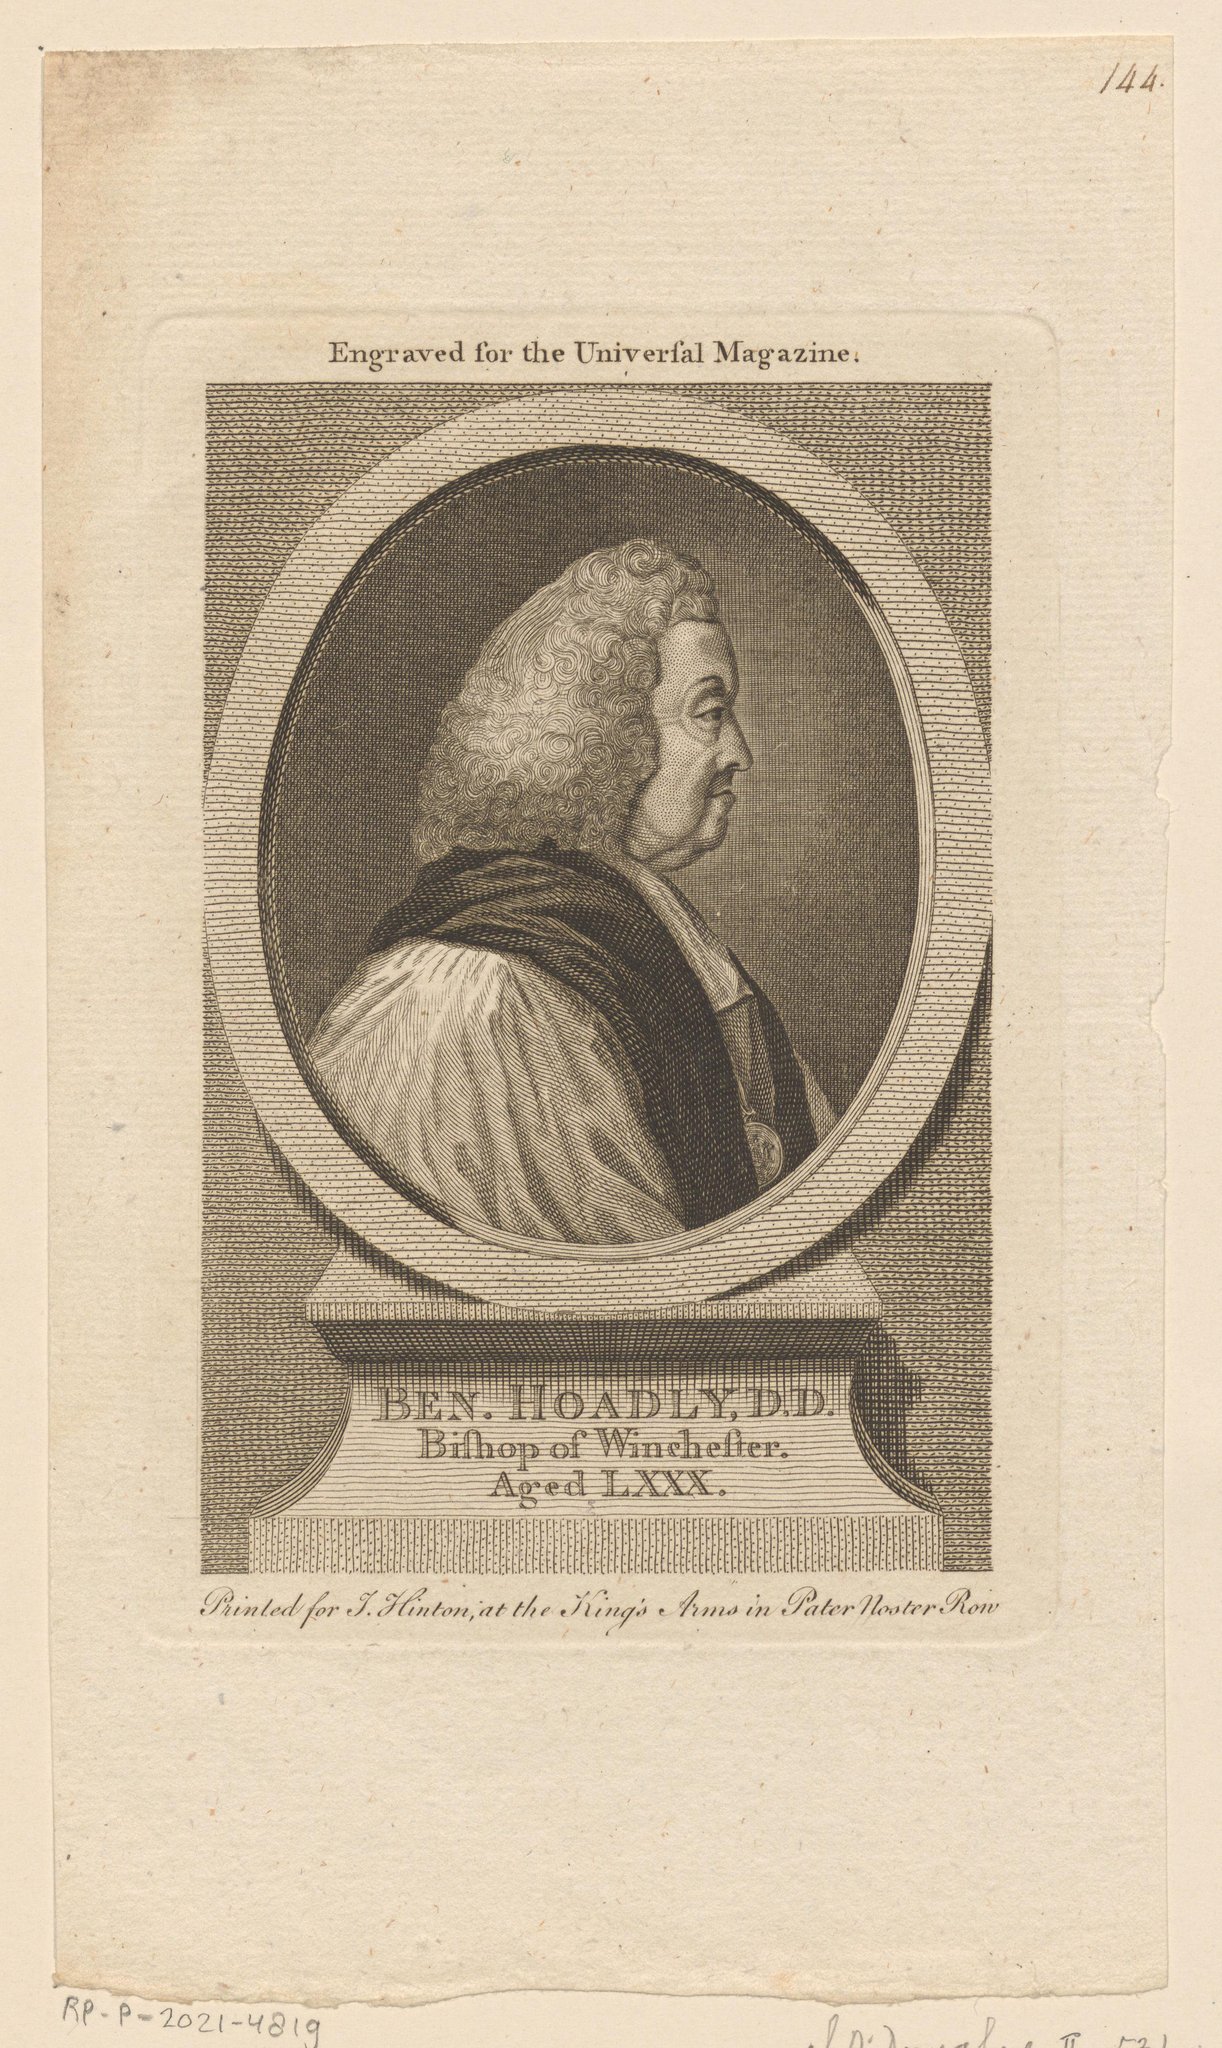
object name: print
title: Portret van Benjamin Hoadly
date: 1756-1781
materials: paper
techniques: engraving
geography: london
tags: priest, archbishop, bishop, etc. (roman catholic), historical persons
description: Prent uit: The Universal Magazine of Knowledge and Pleasure, 1747-1781.